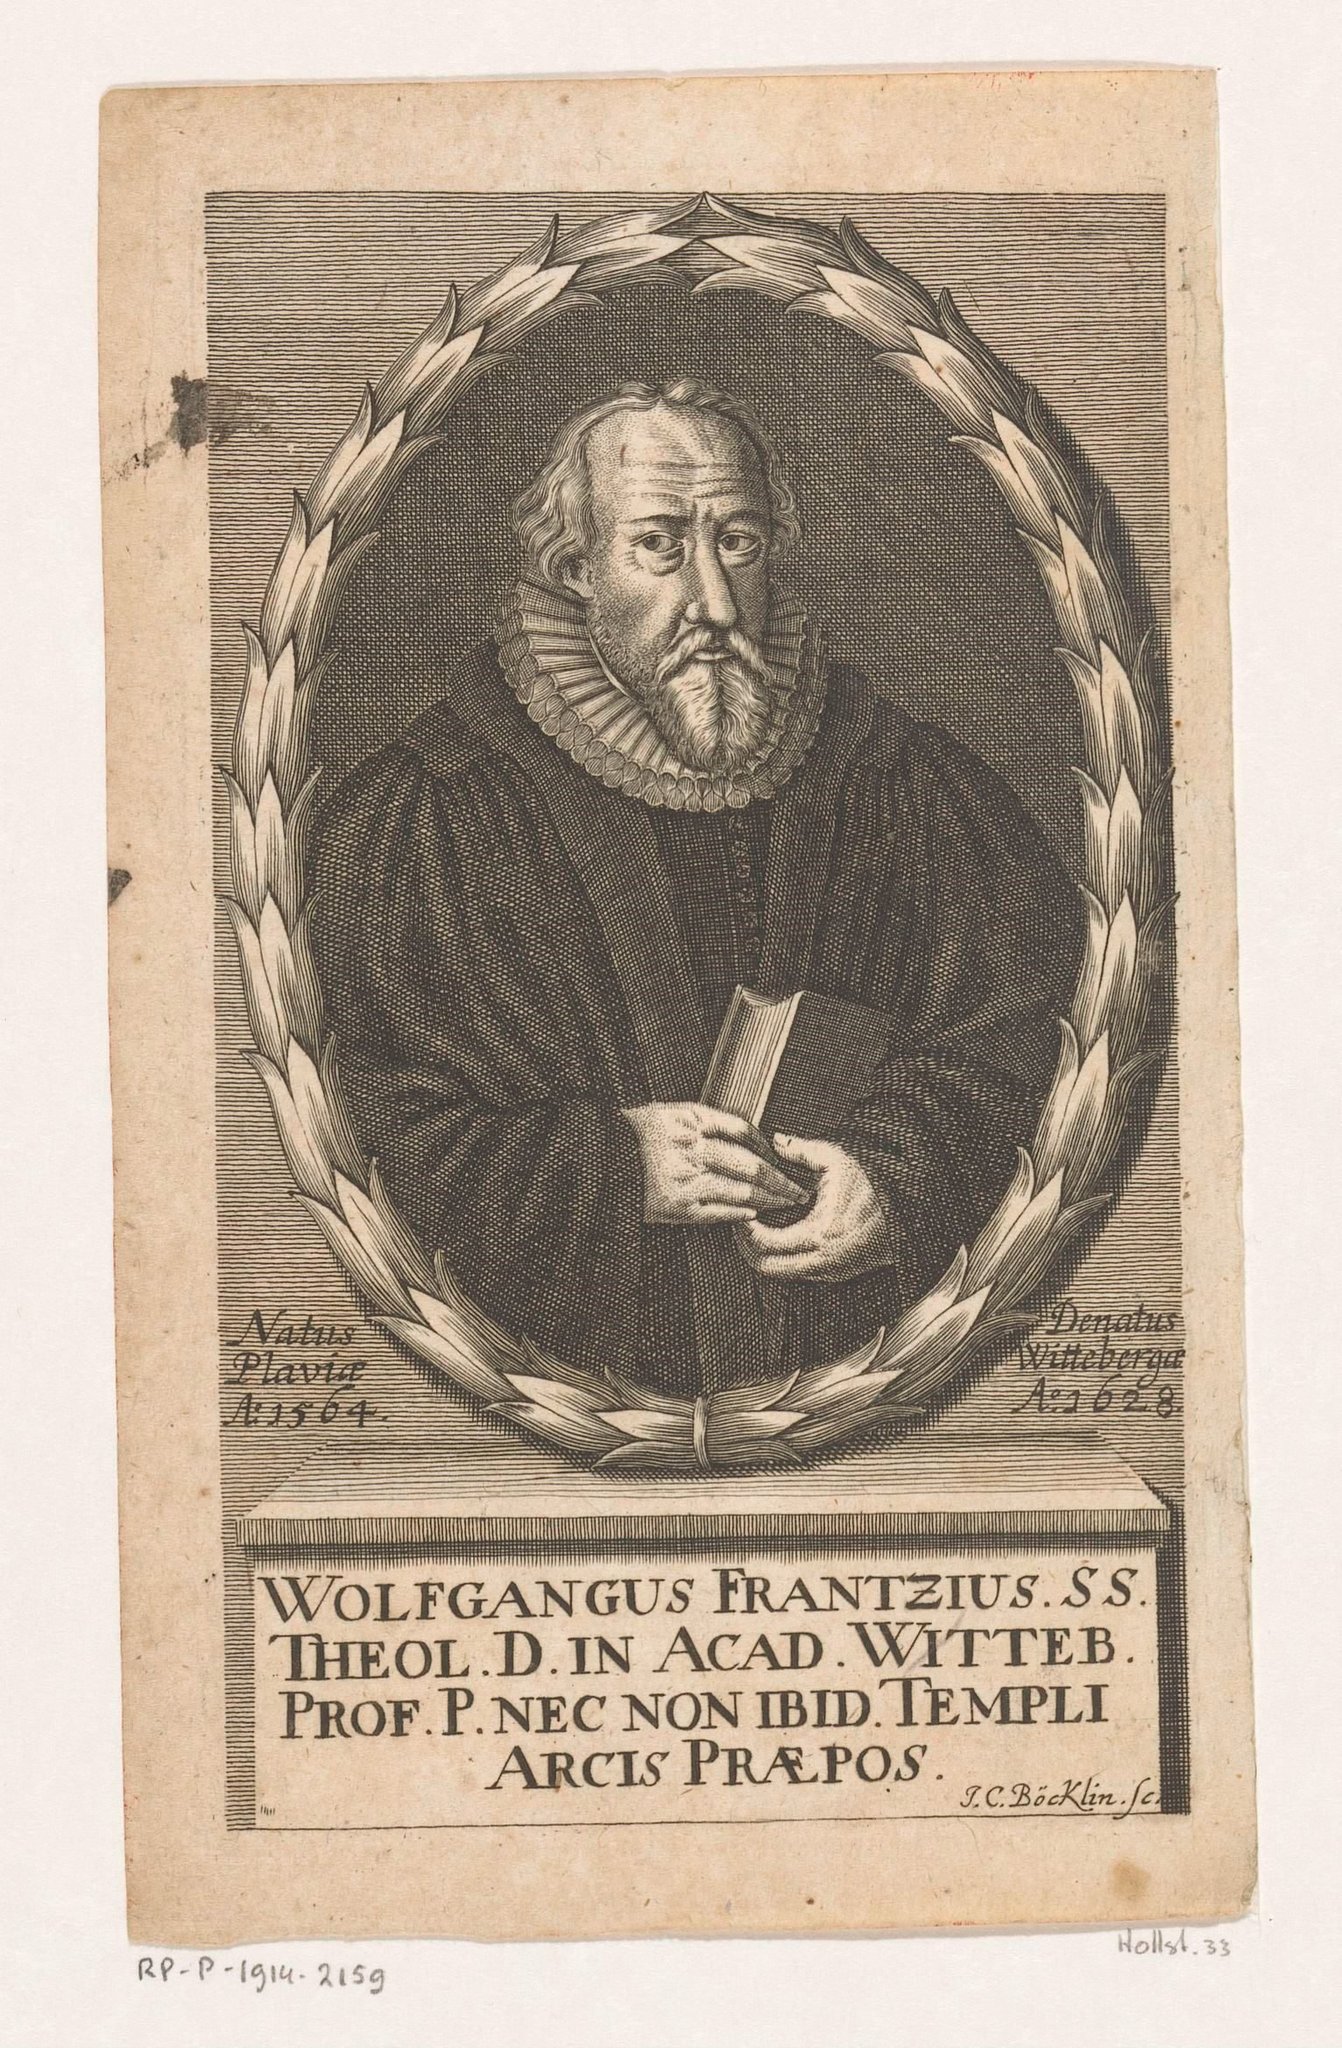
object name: print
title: Portret van Wolfgang Franz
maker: johann christoph boecklin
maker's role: print maker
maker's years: 1657-1709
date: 1667-1709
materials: paper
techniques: engraving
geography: leipzig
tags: historical persons, book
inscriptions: collector's mark: Lugt 2228